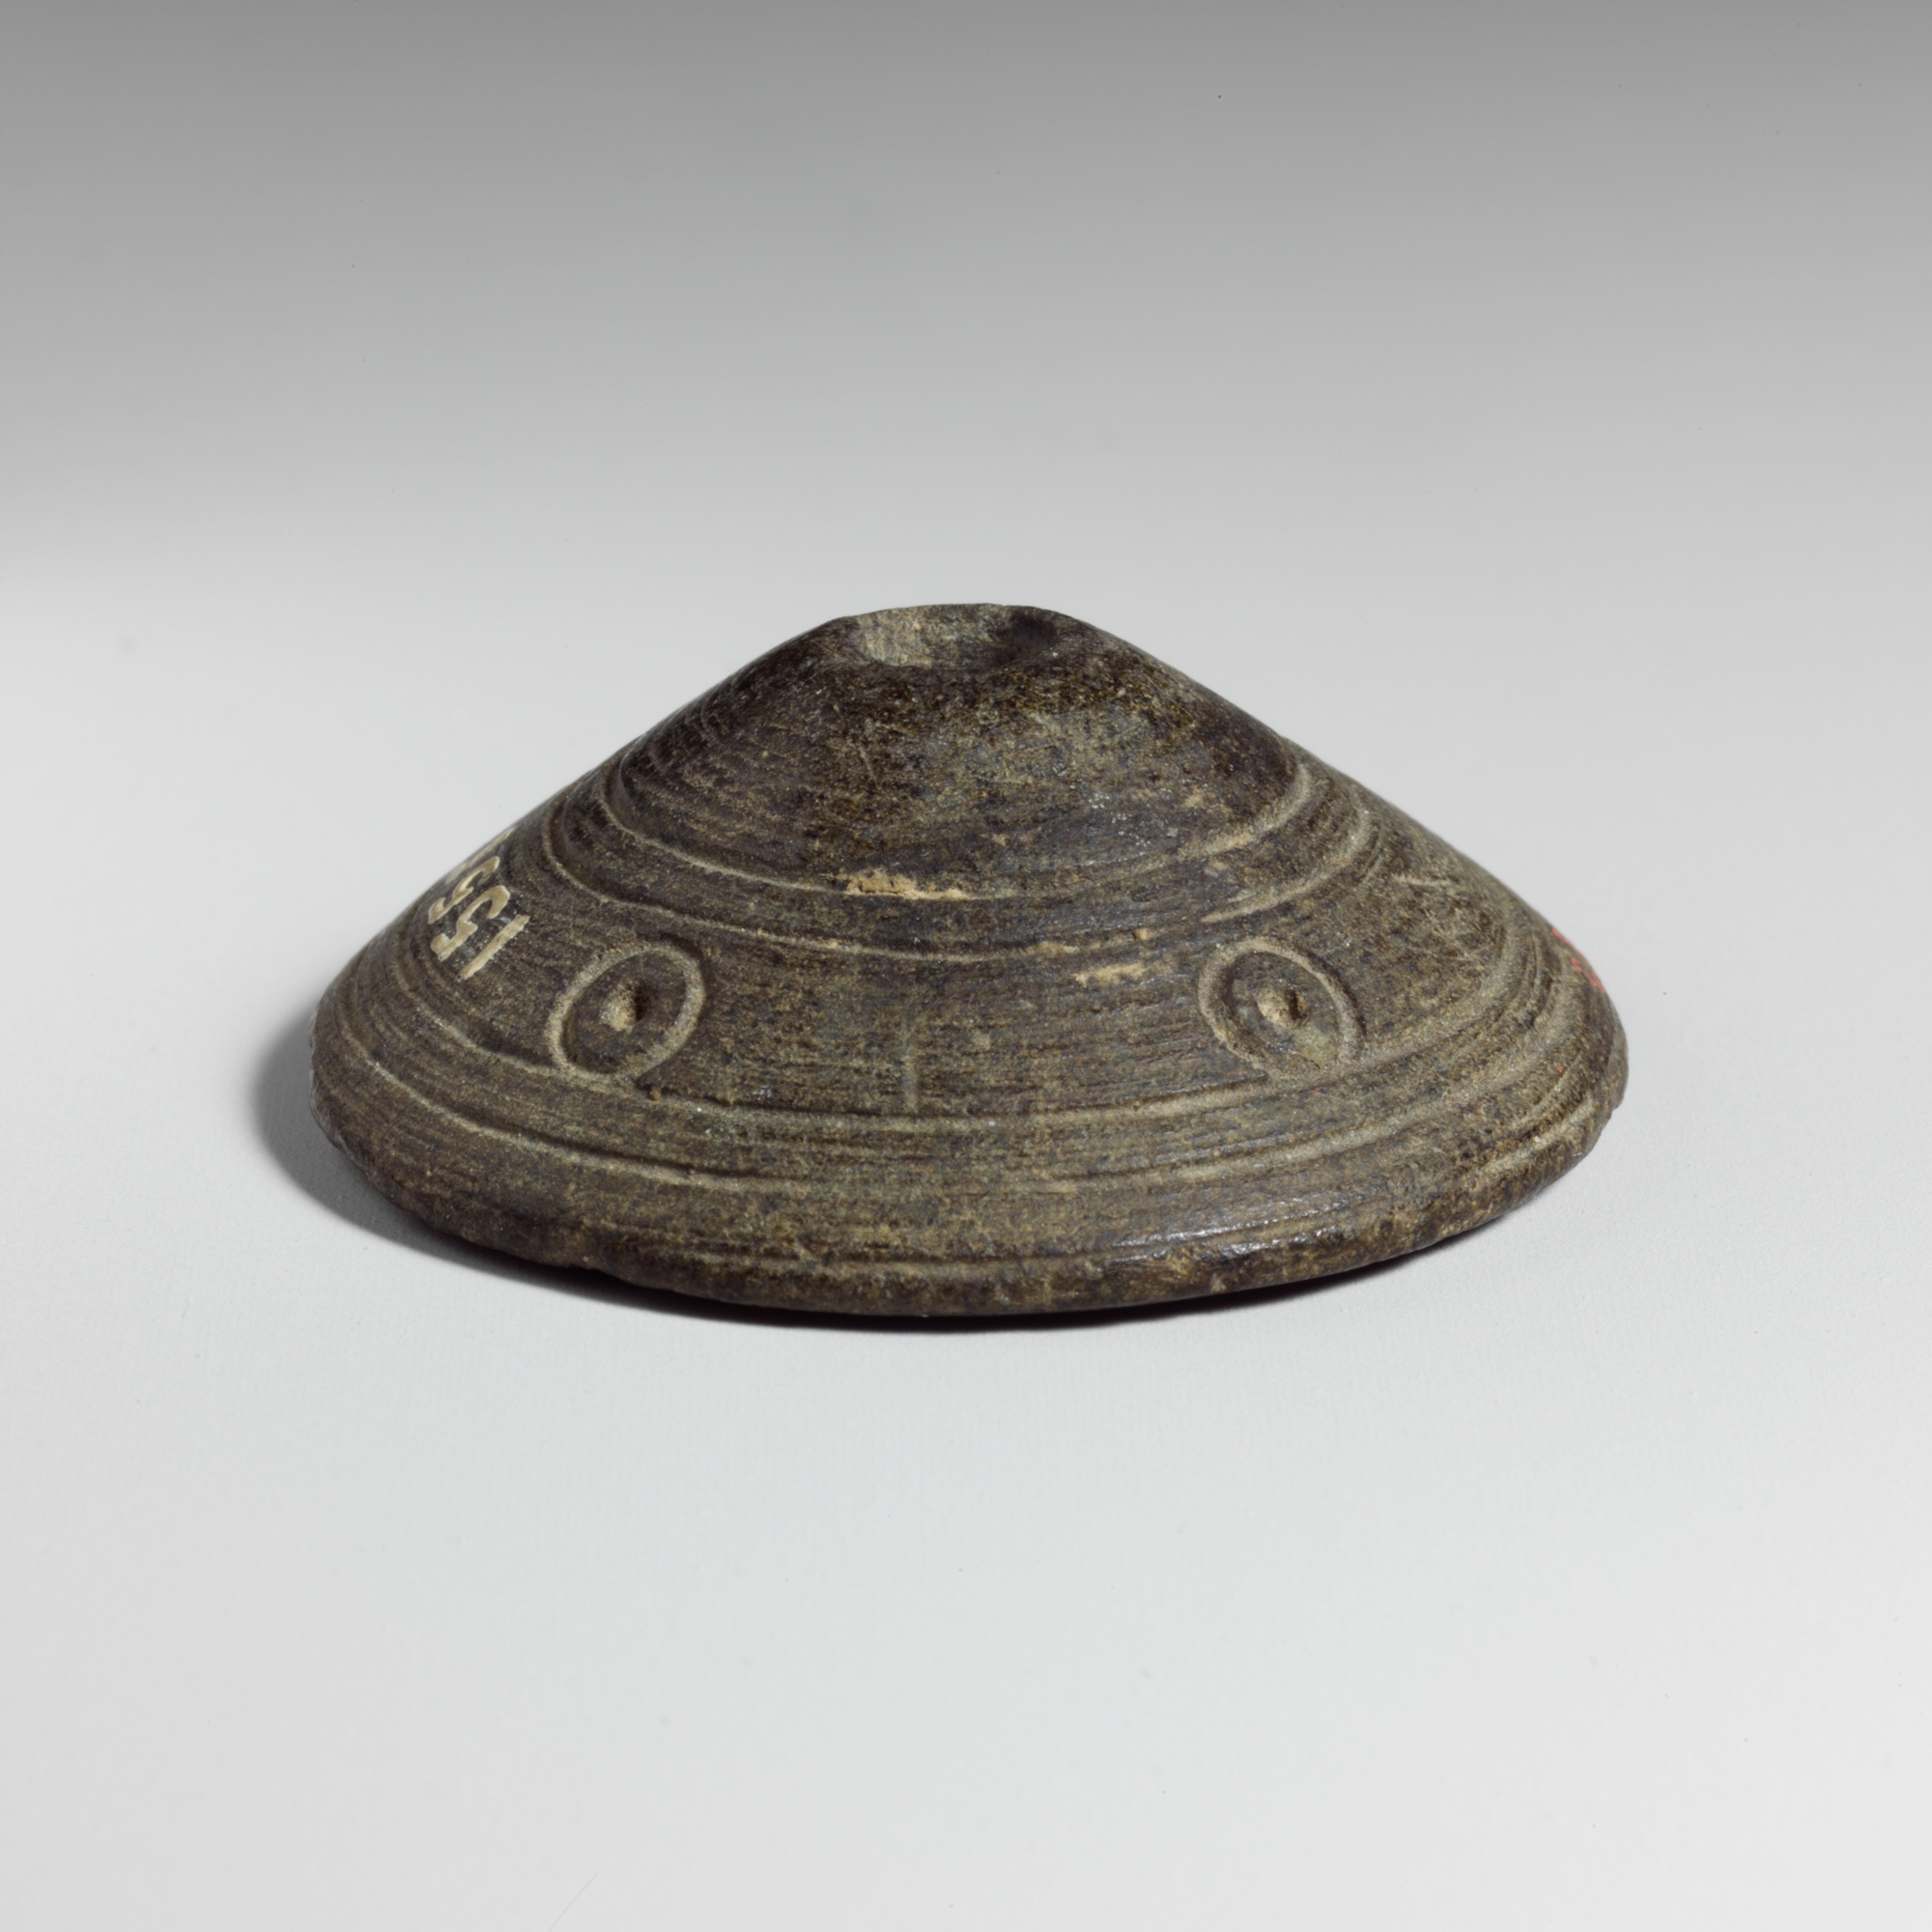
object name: spindle whorl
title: Micaceous schist spindle whorl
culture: cypriot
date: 1200-1050 BCE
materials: stone